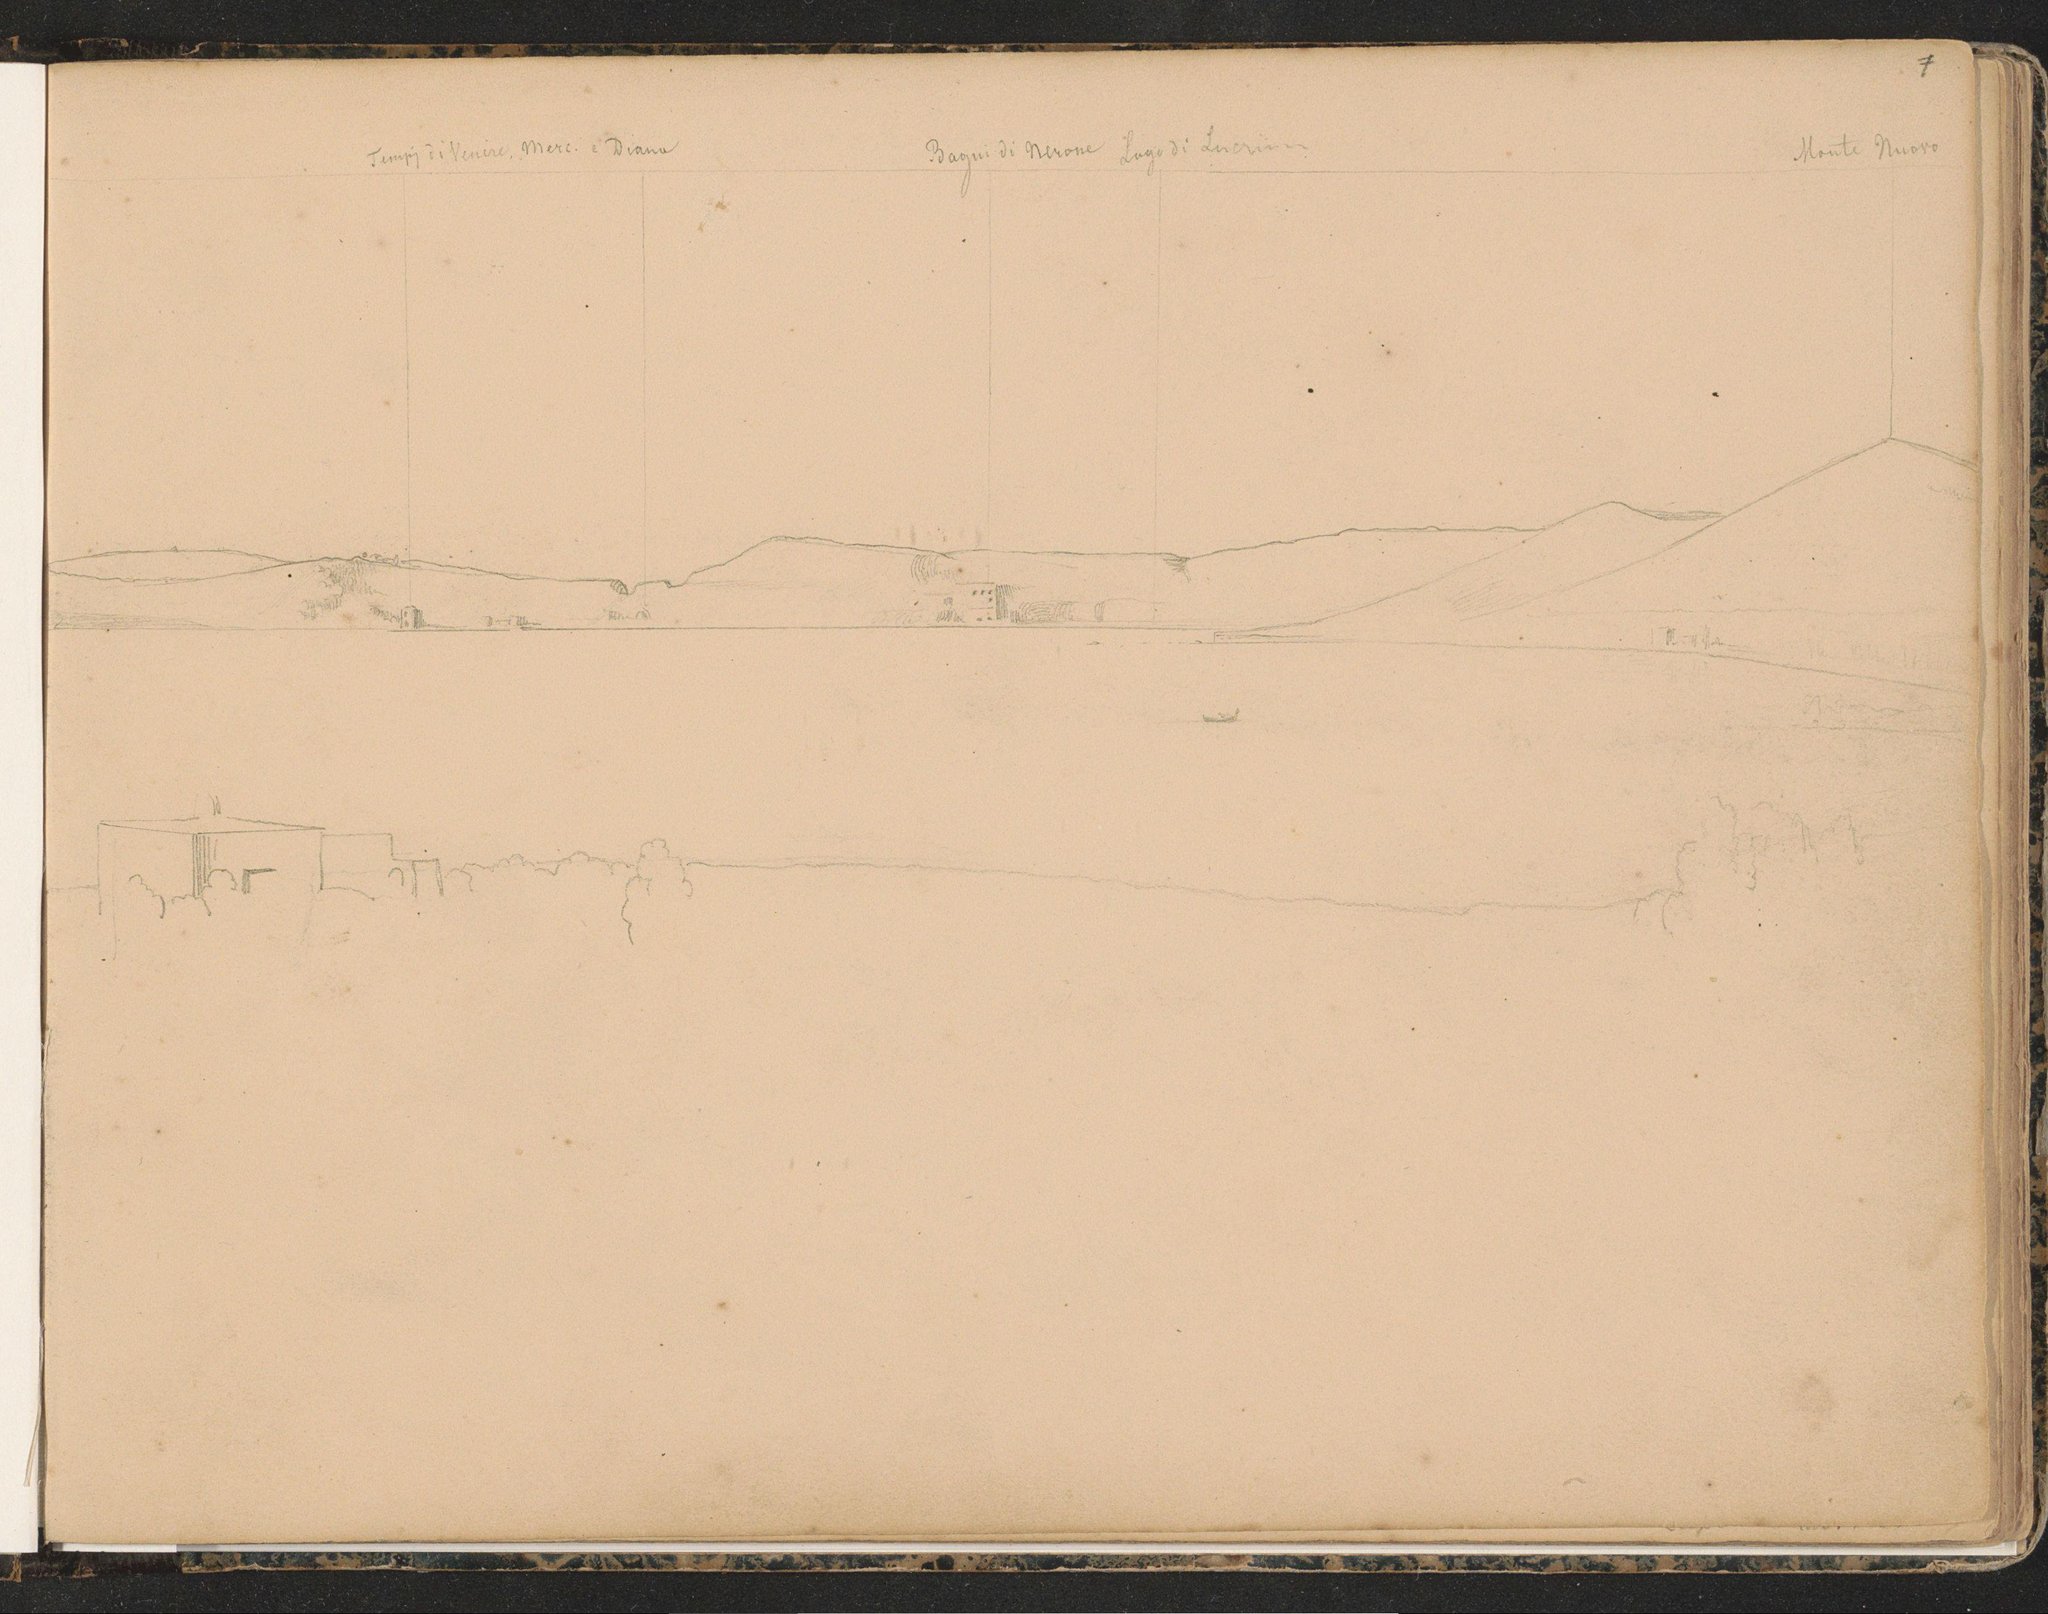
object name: sketchbook leaf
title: Gezicht op Lago di Lucrino en Monte Nuovo bij Napels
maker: jacobus everhardus josephus van den berg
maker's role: draughtsman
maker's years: 1802-1861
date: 1830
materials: paper, pencil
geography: southern italy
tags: city-view, and landscape with man-made constructions, lake, volcano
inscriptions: annotation: ‘Tempio di Venere Merc e Diana/ Bagni di Nerone/ Lago di Lucrino/ Monte Nuovo’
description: Blad 7 recto uit een schetsboek met 26 bladen.